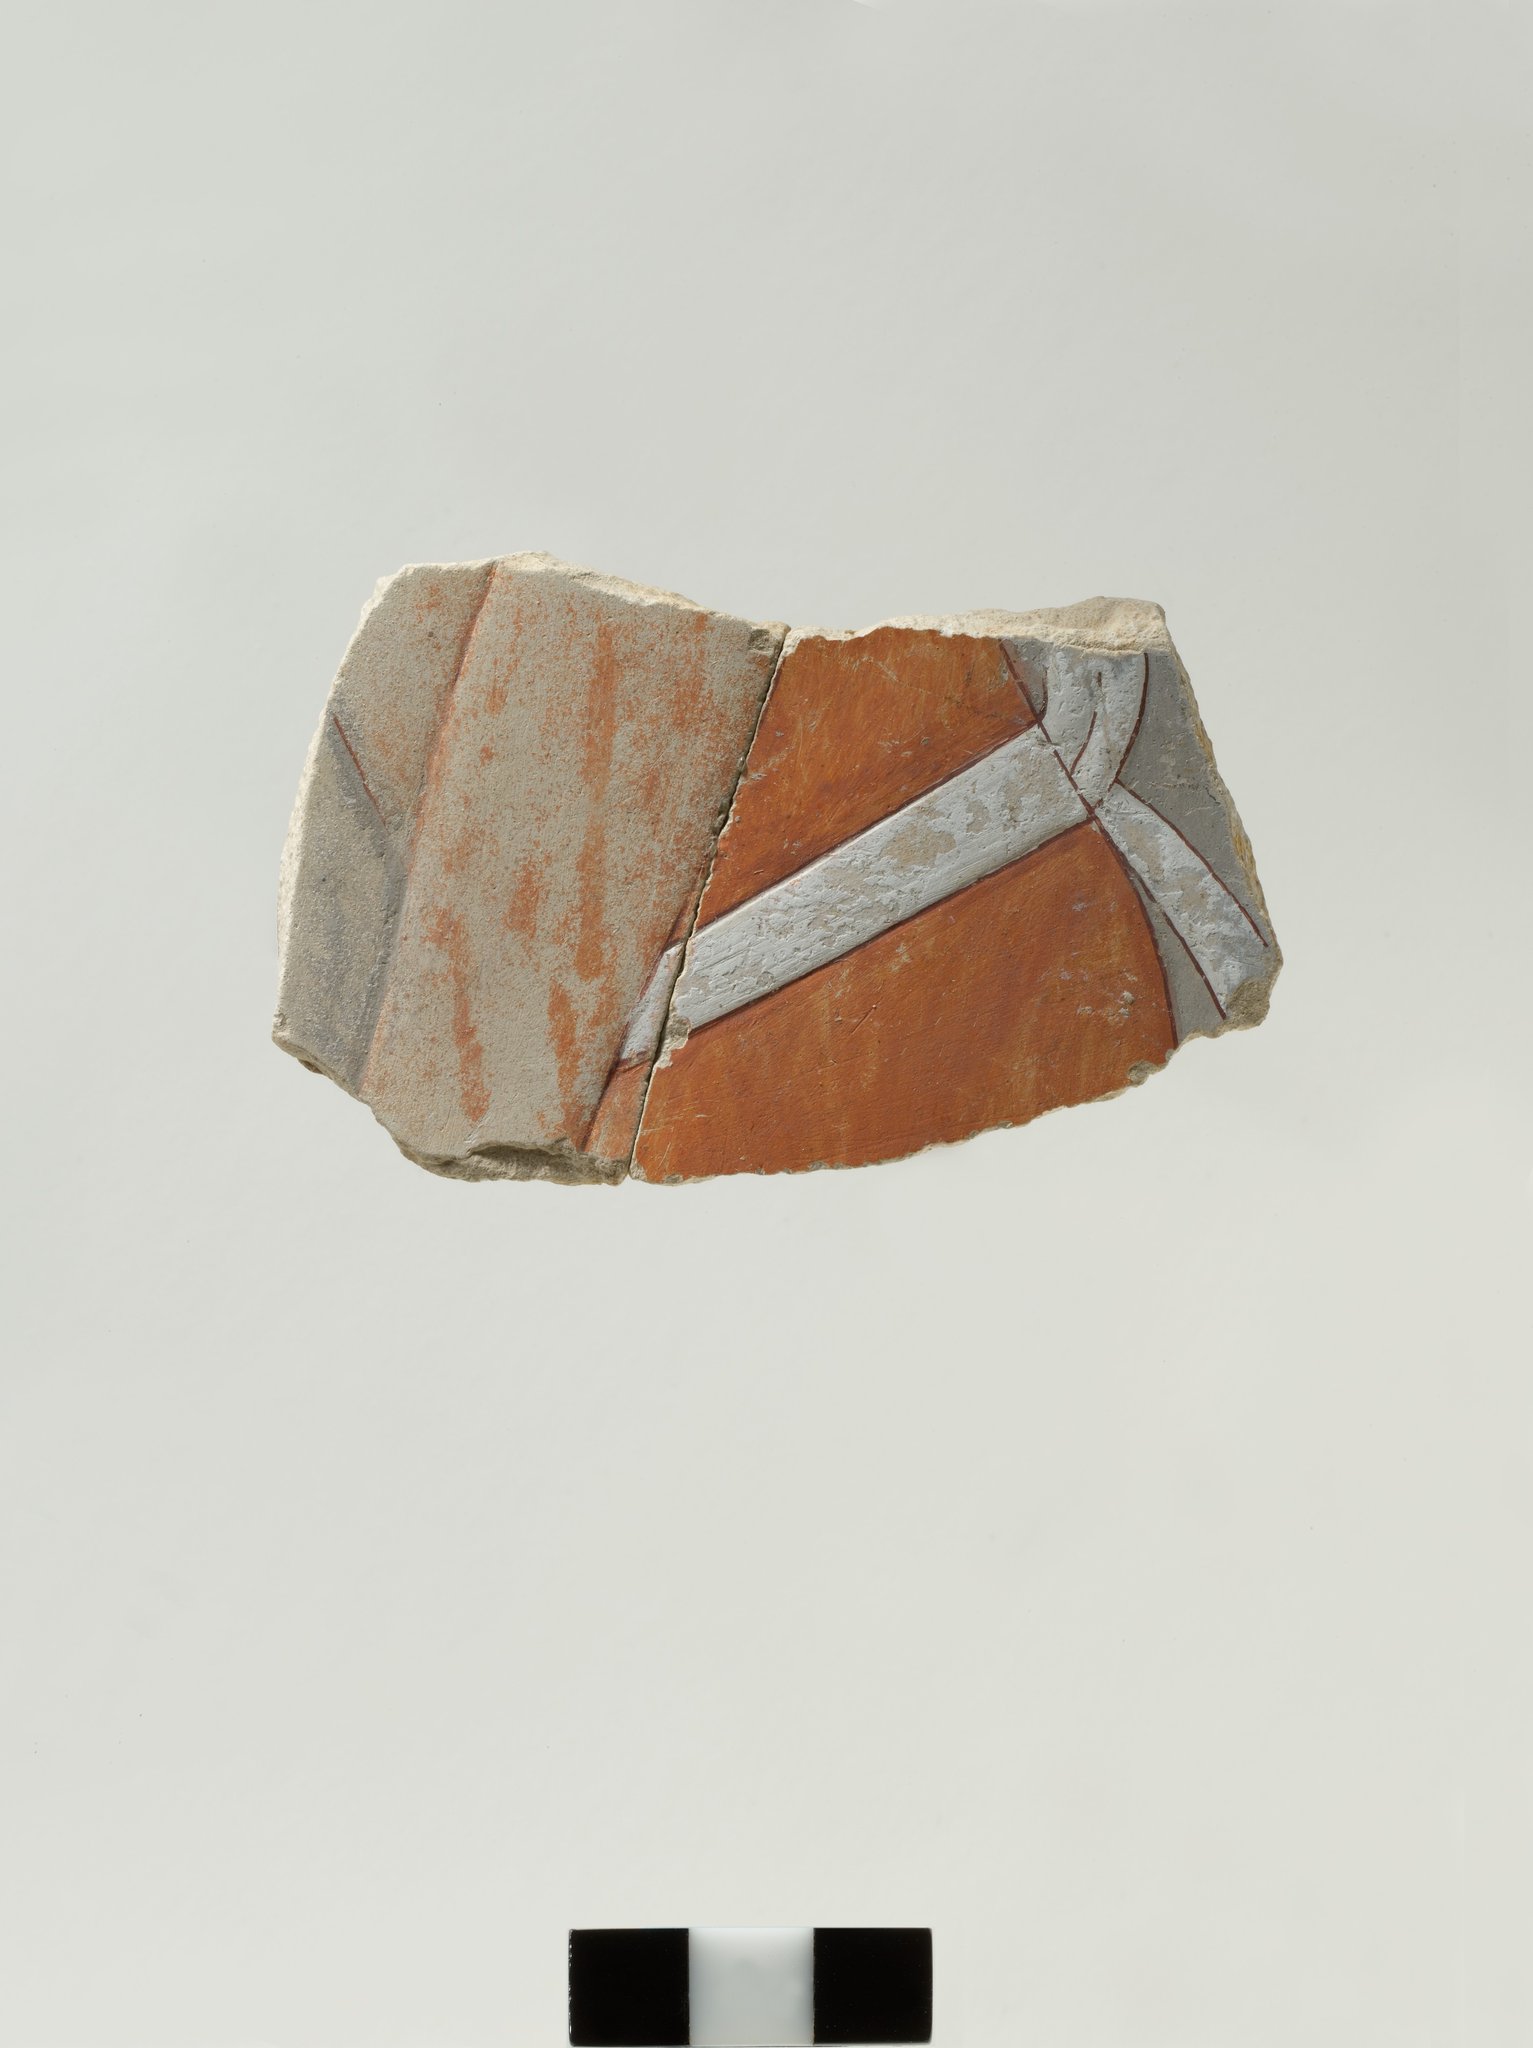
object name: relief fragment, tomb of meketre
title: Relief fragments from the tomb of Meketre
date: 1981-1975 BCE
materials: limestone, paint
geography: egypt